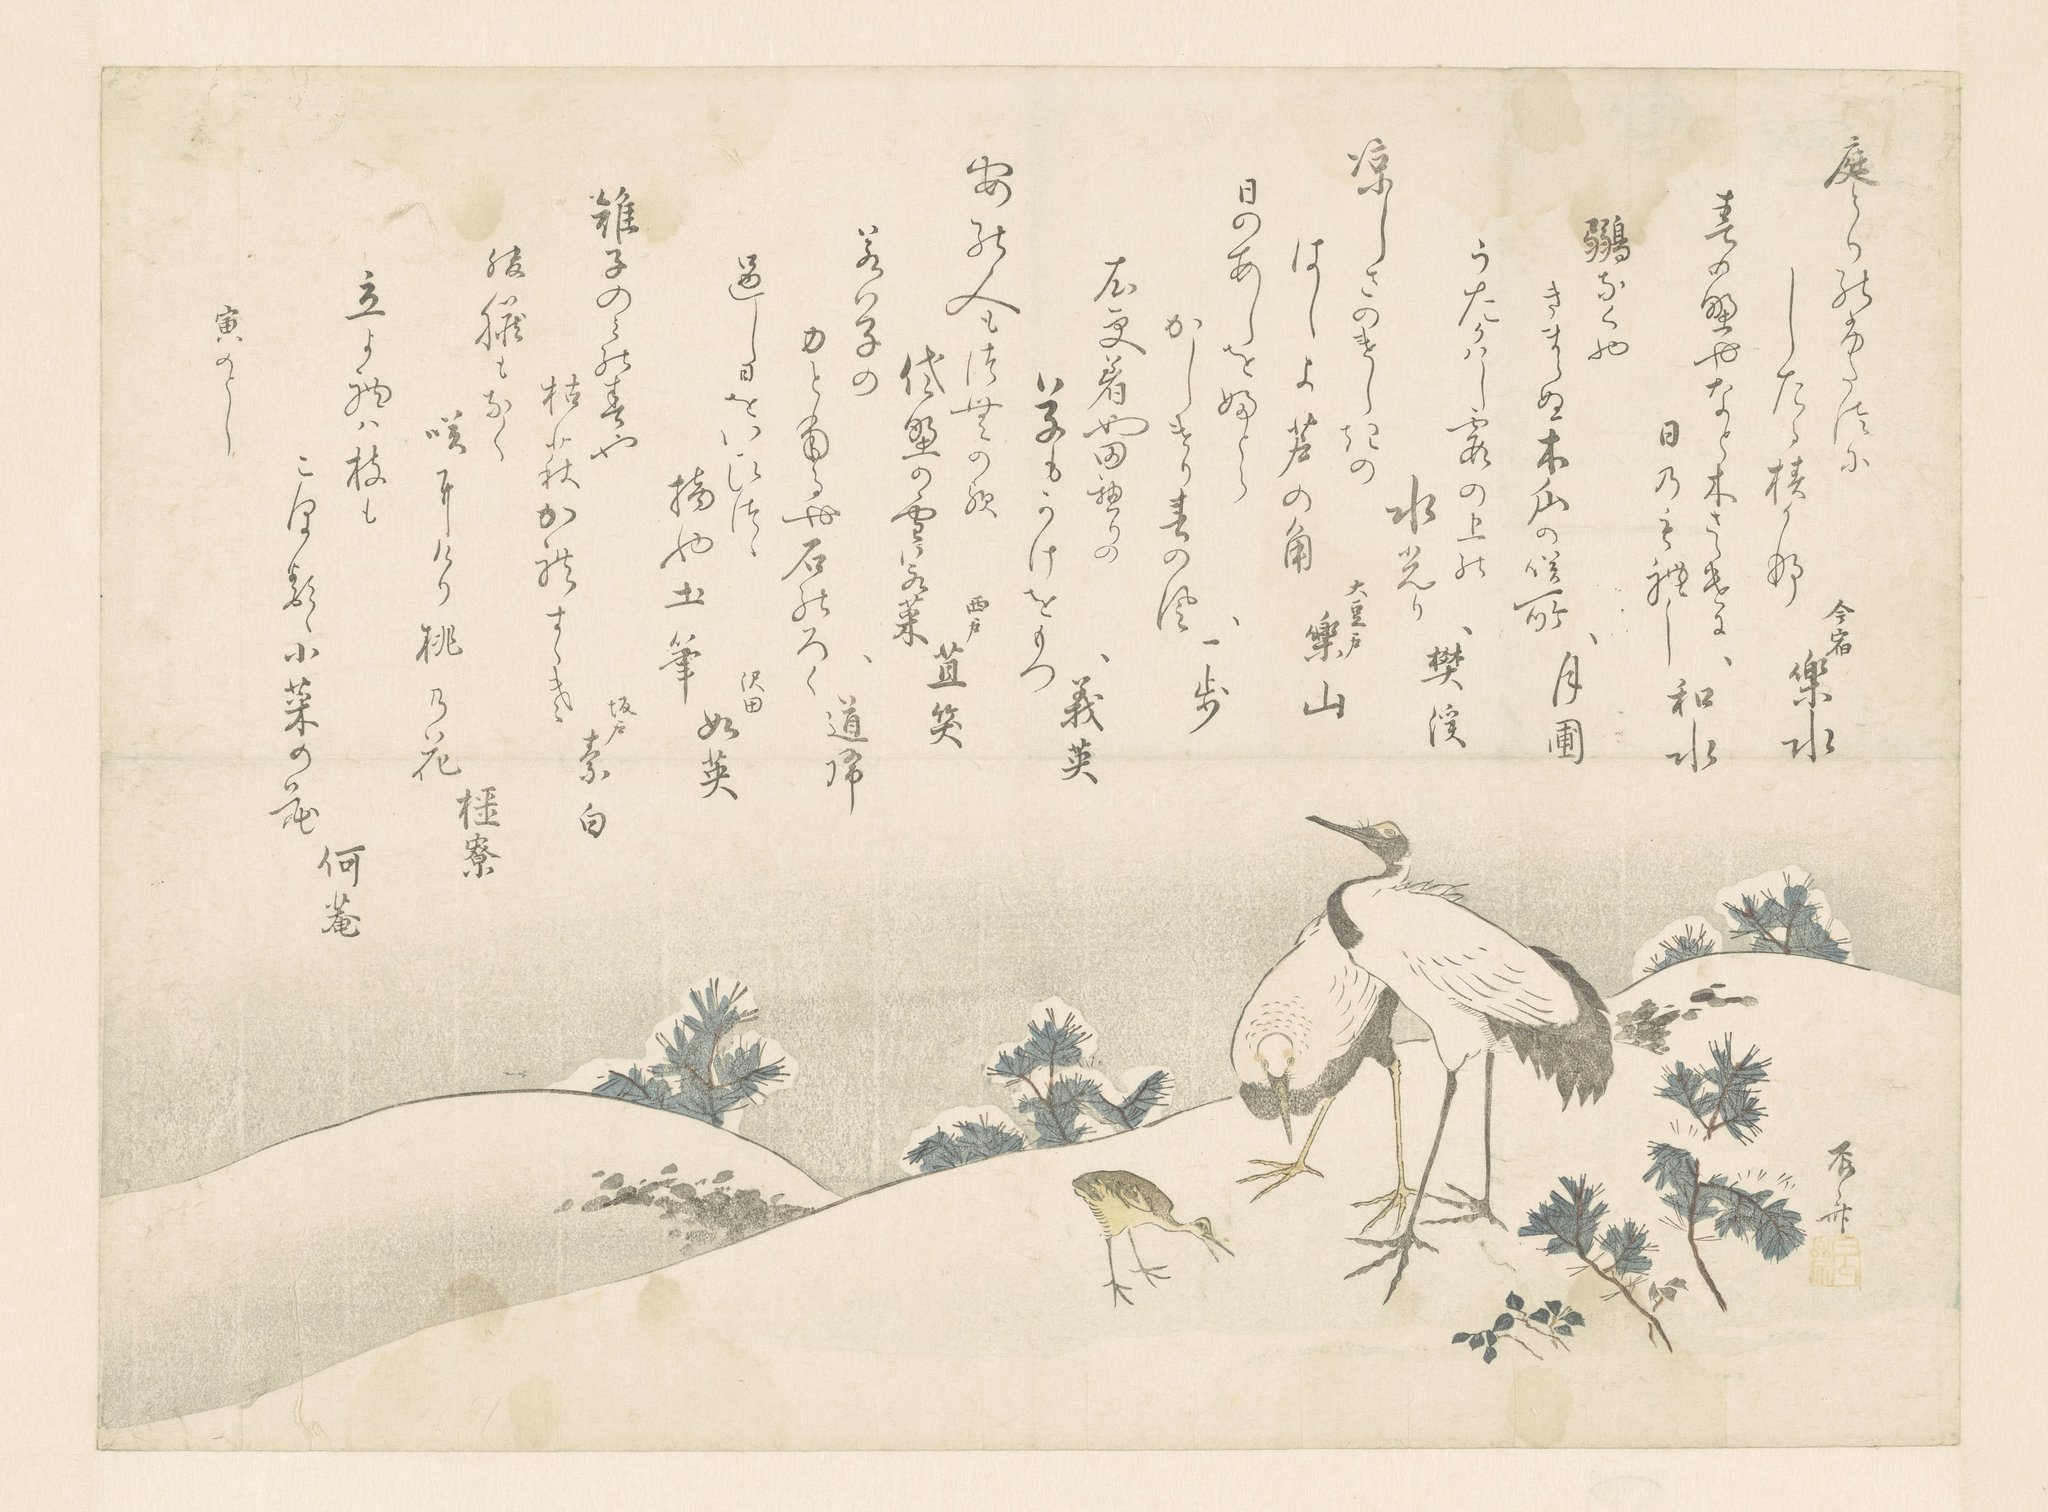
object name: surimono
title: Gedichten en kraanvogels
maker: ryûryûkyo shinsai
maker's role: draughtsman, print maker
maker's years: 1764-1825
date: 1774-1825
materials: paper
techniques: woodcut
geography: japan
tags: shore-birds and wading-birds: crane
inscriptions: collector's mark: Lugt 2228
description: Een surimono is een luxe uitgevoerde prent waarop beeld met één of meerdere gedichten gecombineerd is. Bij het drukken van een surimono werd vaak gebruik gemaakt van dikker papier, blinddruk en metaal pigmenten, zoals koper- en zilverpoeder. De prenten werden vaak in opdracht van dichters gemaakt en als exclusief geschenk aan vrienden en relaties gegeven.